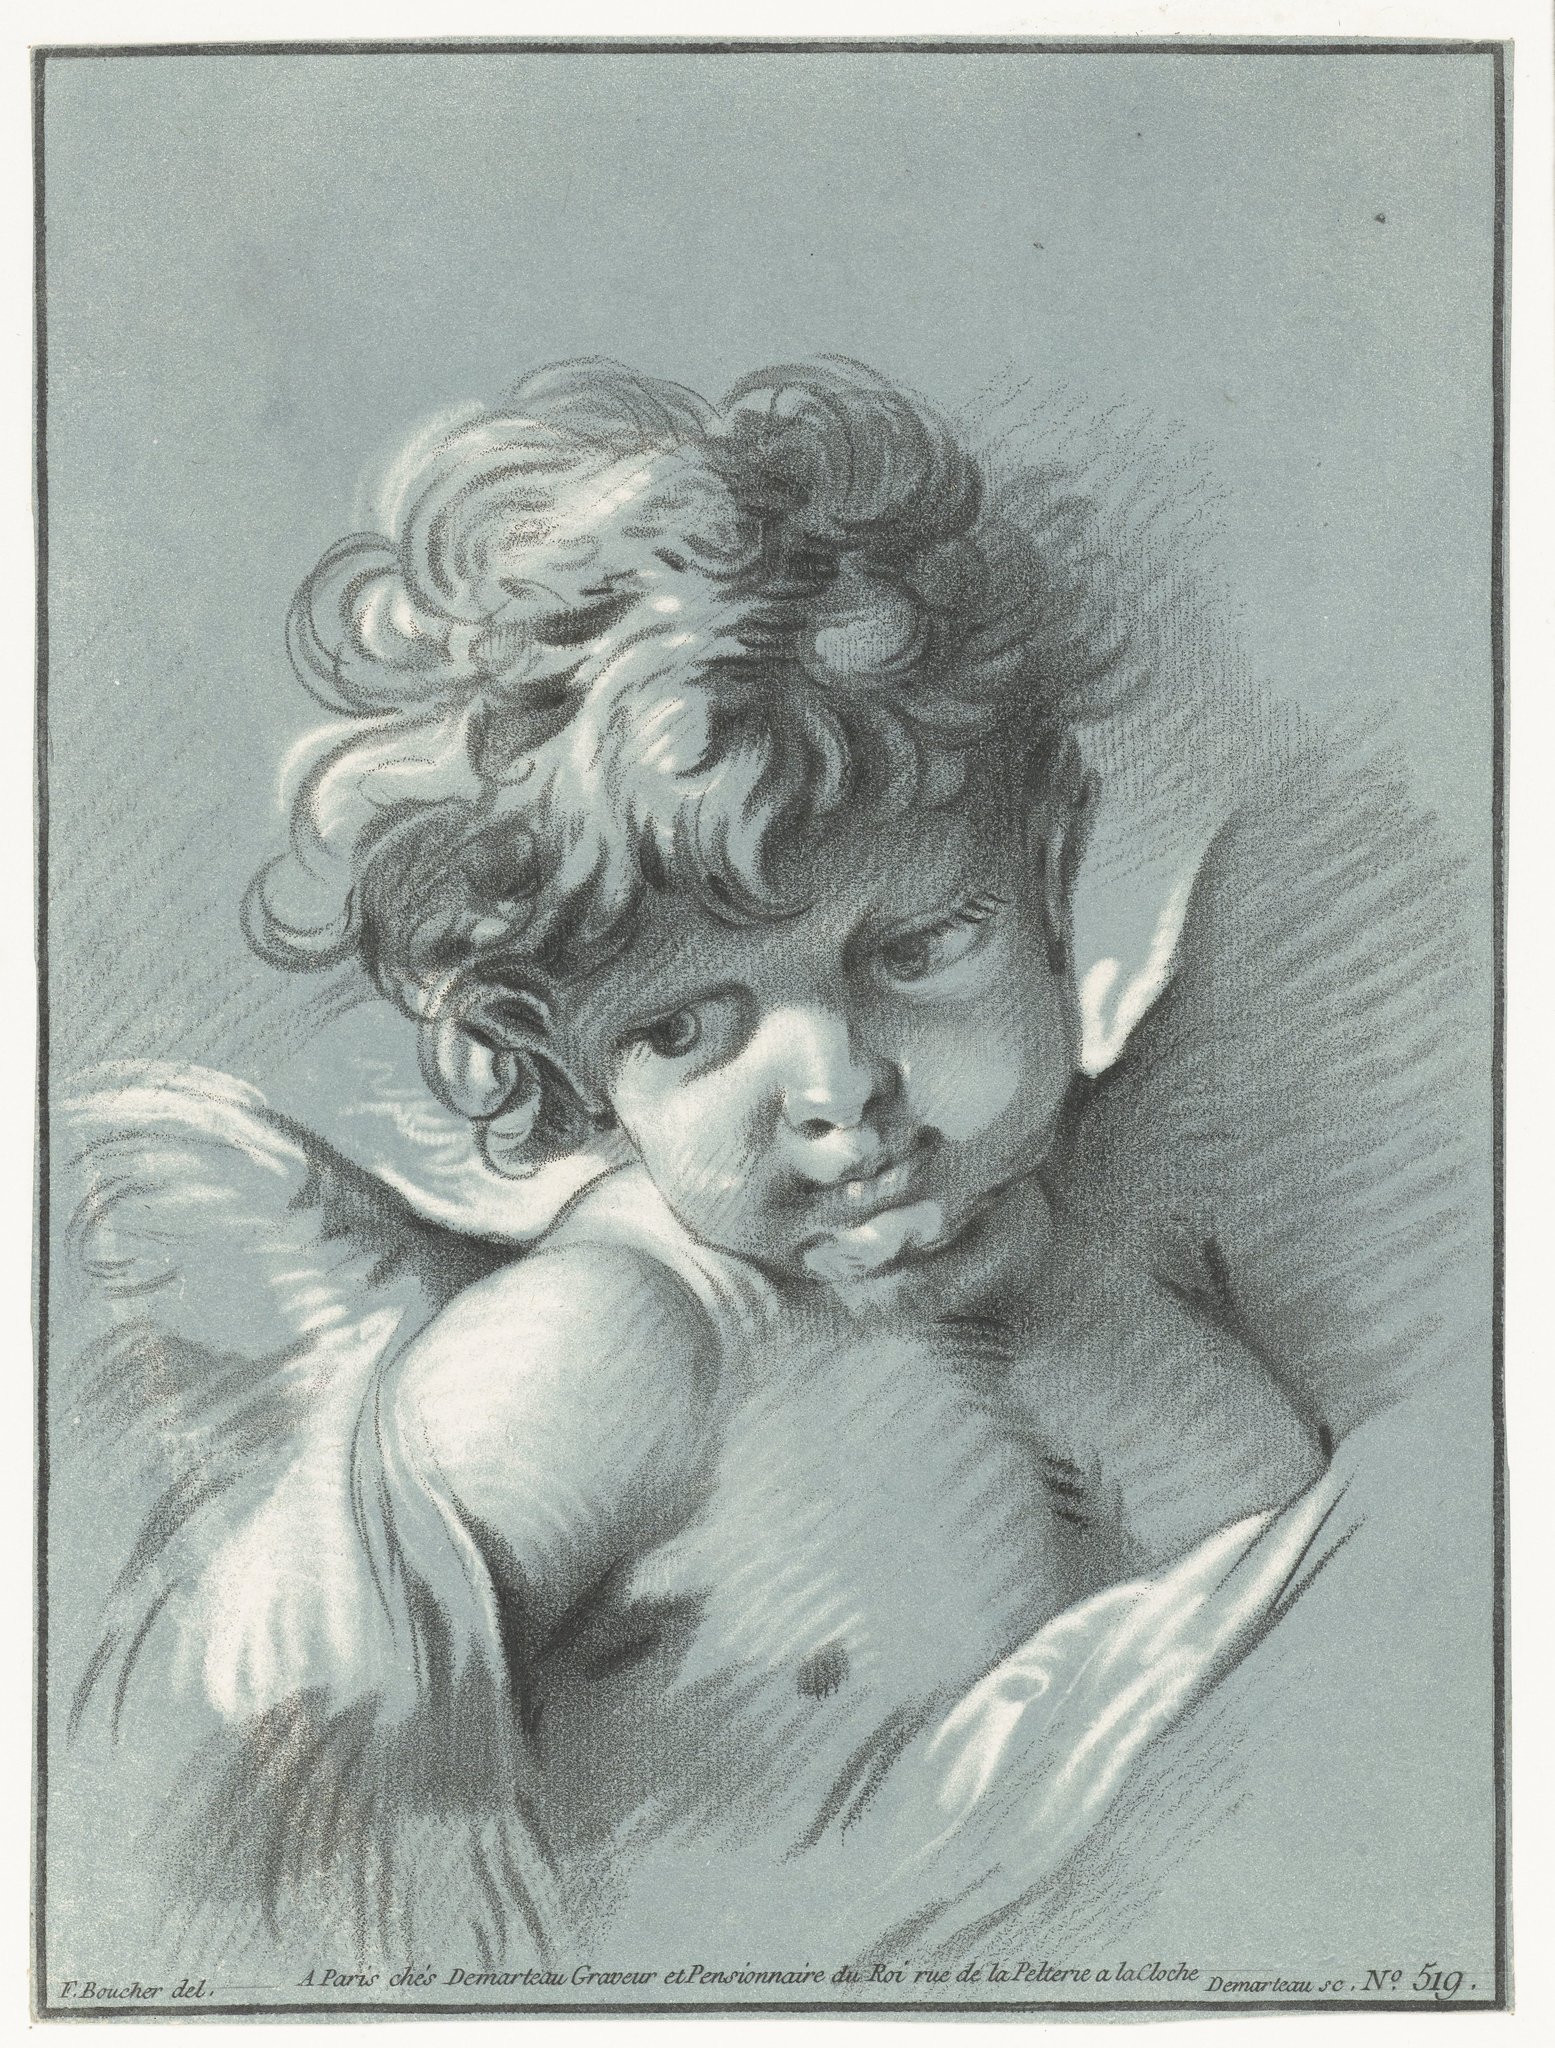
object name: print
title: Buste d'Amour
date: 1756-1776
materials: paper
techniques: printmaking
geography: paris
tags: cupids: 'amores', 'amoretti', 'putti'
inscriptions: collector's mark: Lugt 2233, number: ‘No. 519’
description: Buste van een putto, met zijn ogen kijkend naar links.